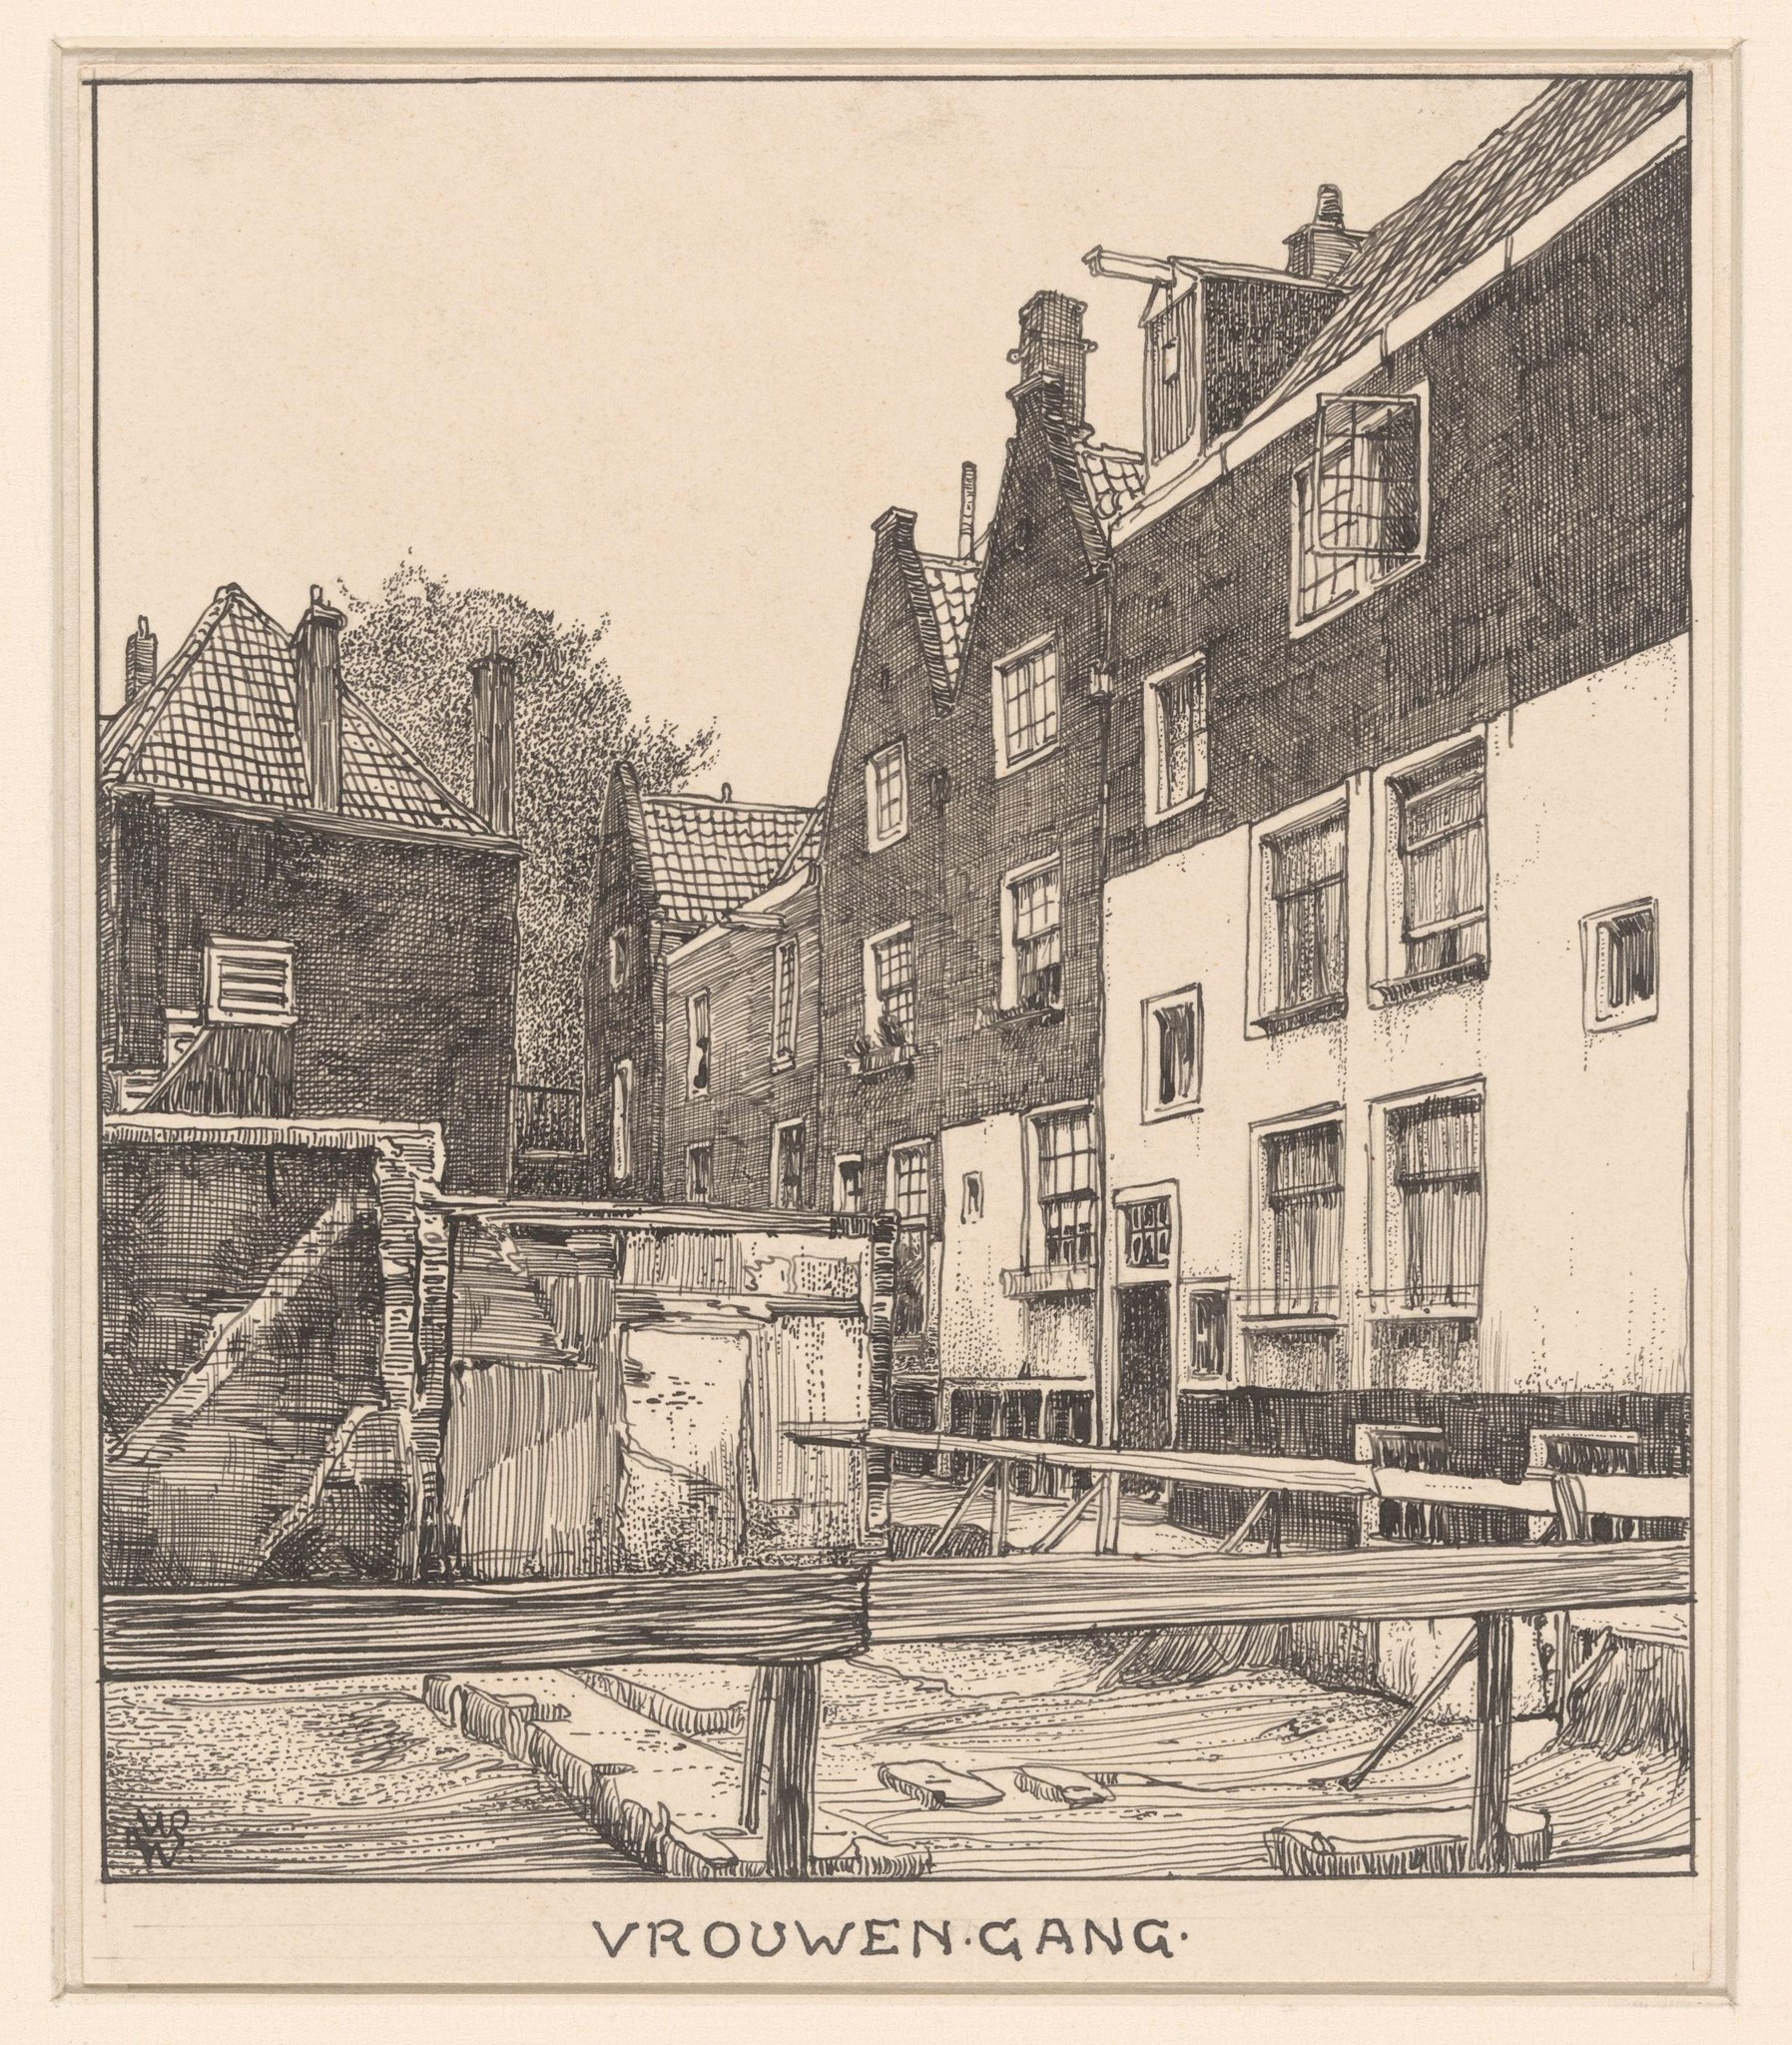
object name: drawing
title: Vrouwen Gang te Amsterdam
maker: willem wenckebach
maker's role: designer, draughtsman, painter, print maker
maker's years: 1860-1937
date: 1870-1926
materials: ink, paper, pencil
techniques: pen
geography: amsterdam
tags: street, amsterdam